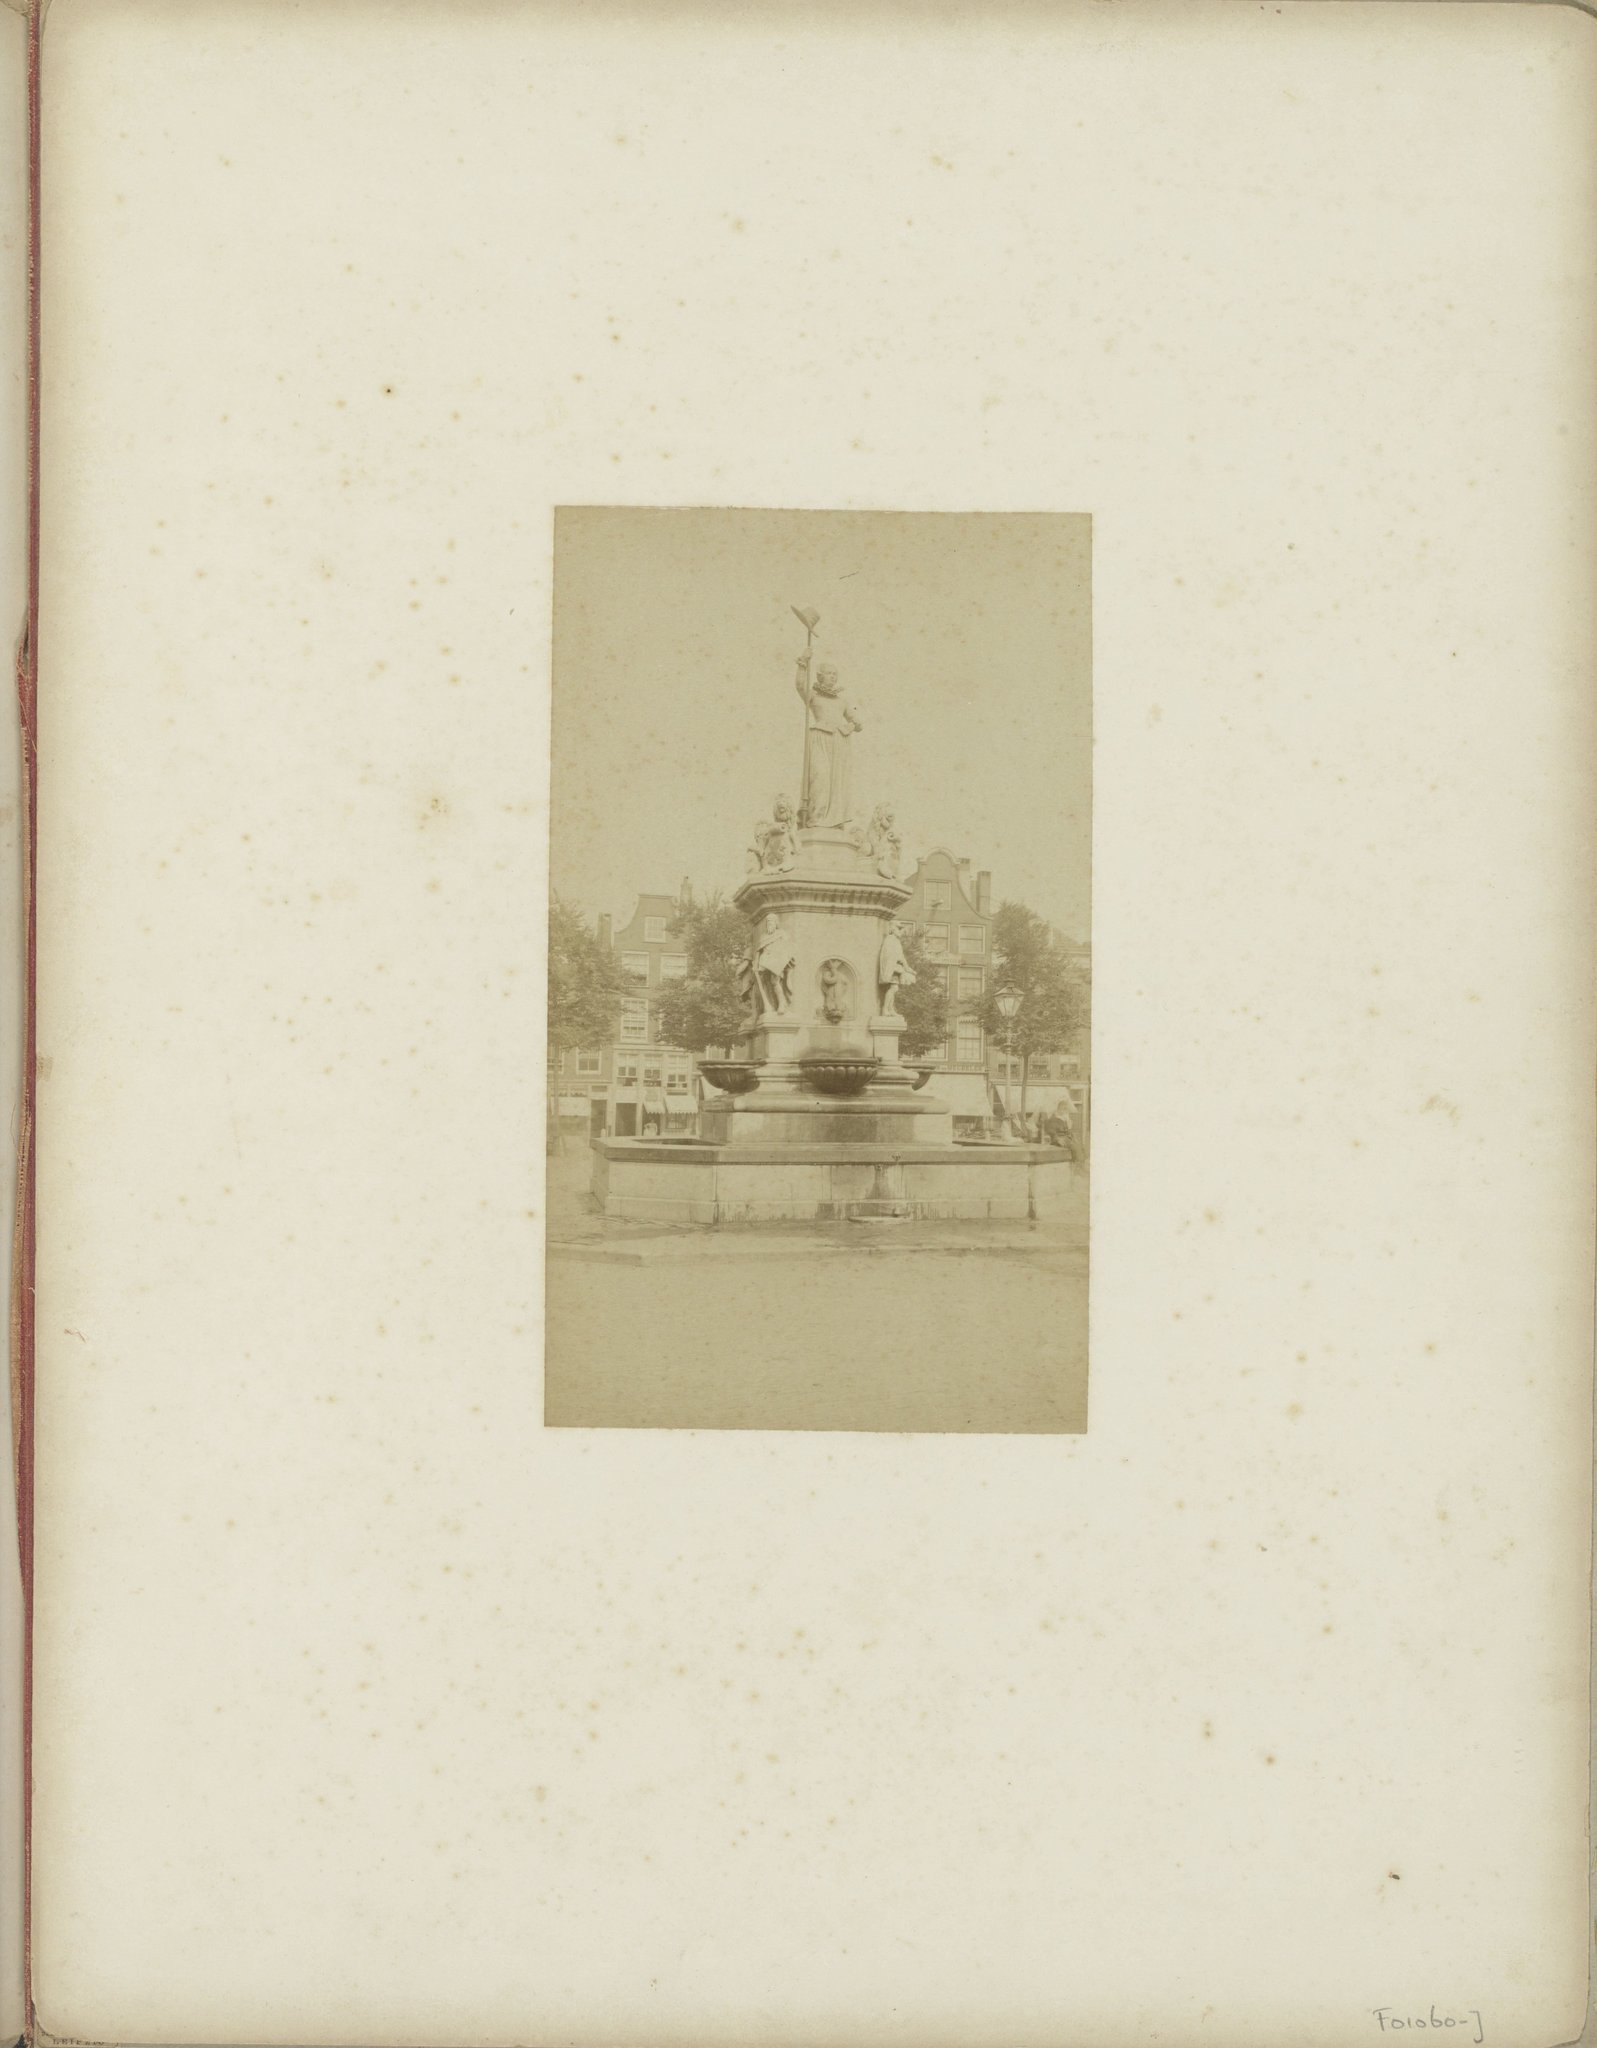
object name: photograph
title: Standbeeld De Maagd van Holland alias Kaat Mossel op de Nieuwe Markt te Rotterdam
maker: Anonymous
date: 1880-1900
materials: photographic support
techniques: albumen print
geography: rotterdam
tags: rotterdam, kaat mossel, monument, statue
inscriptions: inscription: ‘Nieuwe Markt’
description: Onderdeel van Fotoalbum met stadsgezichten van Rotterdam.